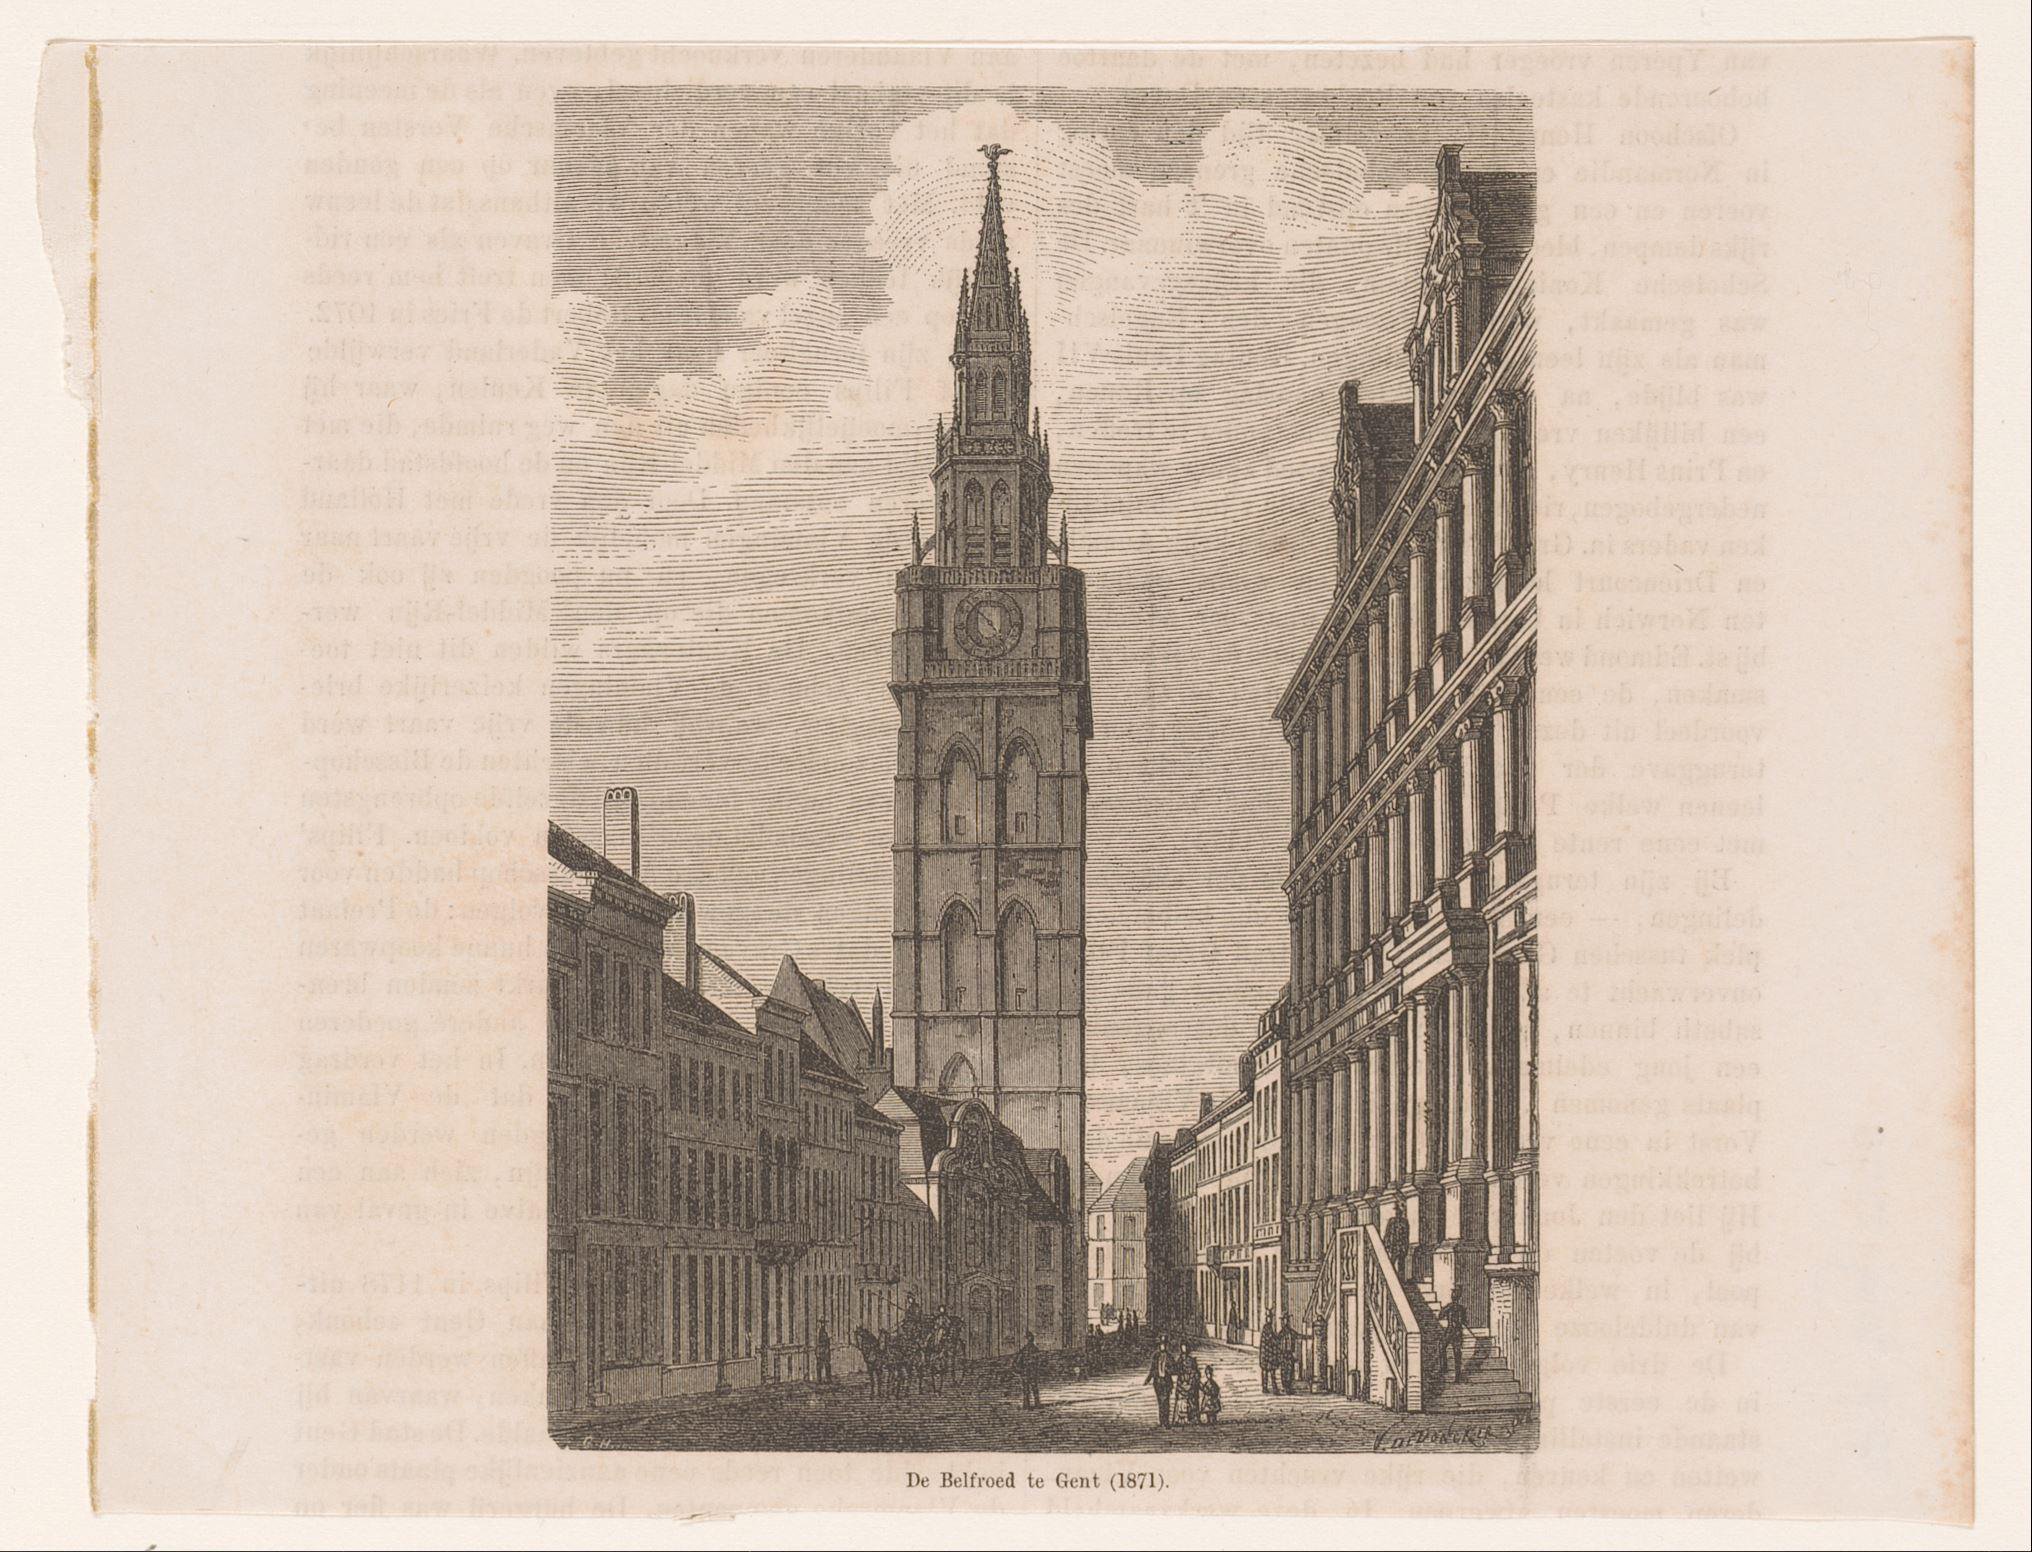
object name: book illustration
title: De Belfroed te Gent (1871)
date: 1837-1881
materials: paper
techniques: letterpress printing, engraving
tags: tower, clock tower ~ monumental adornment